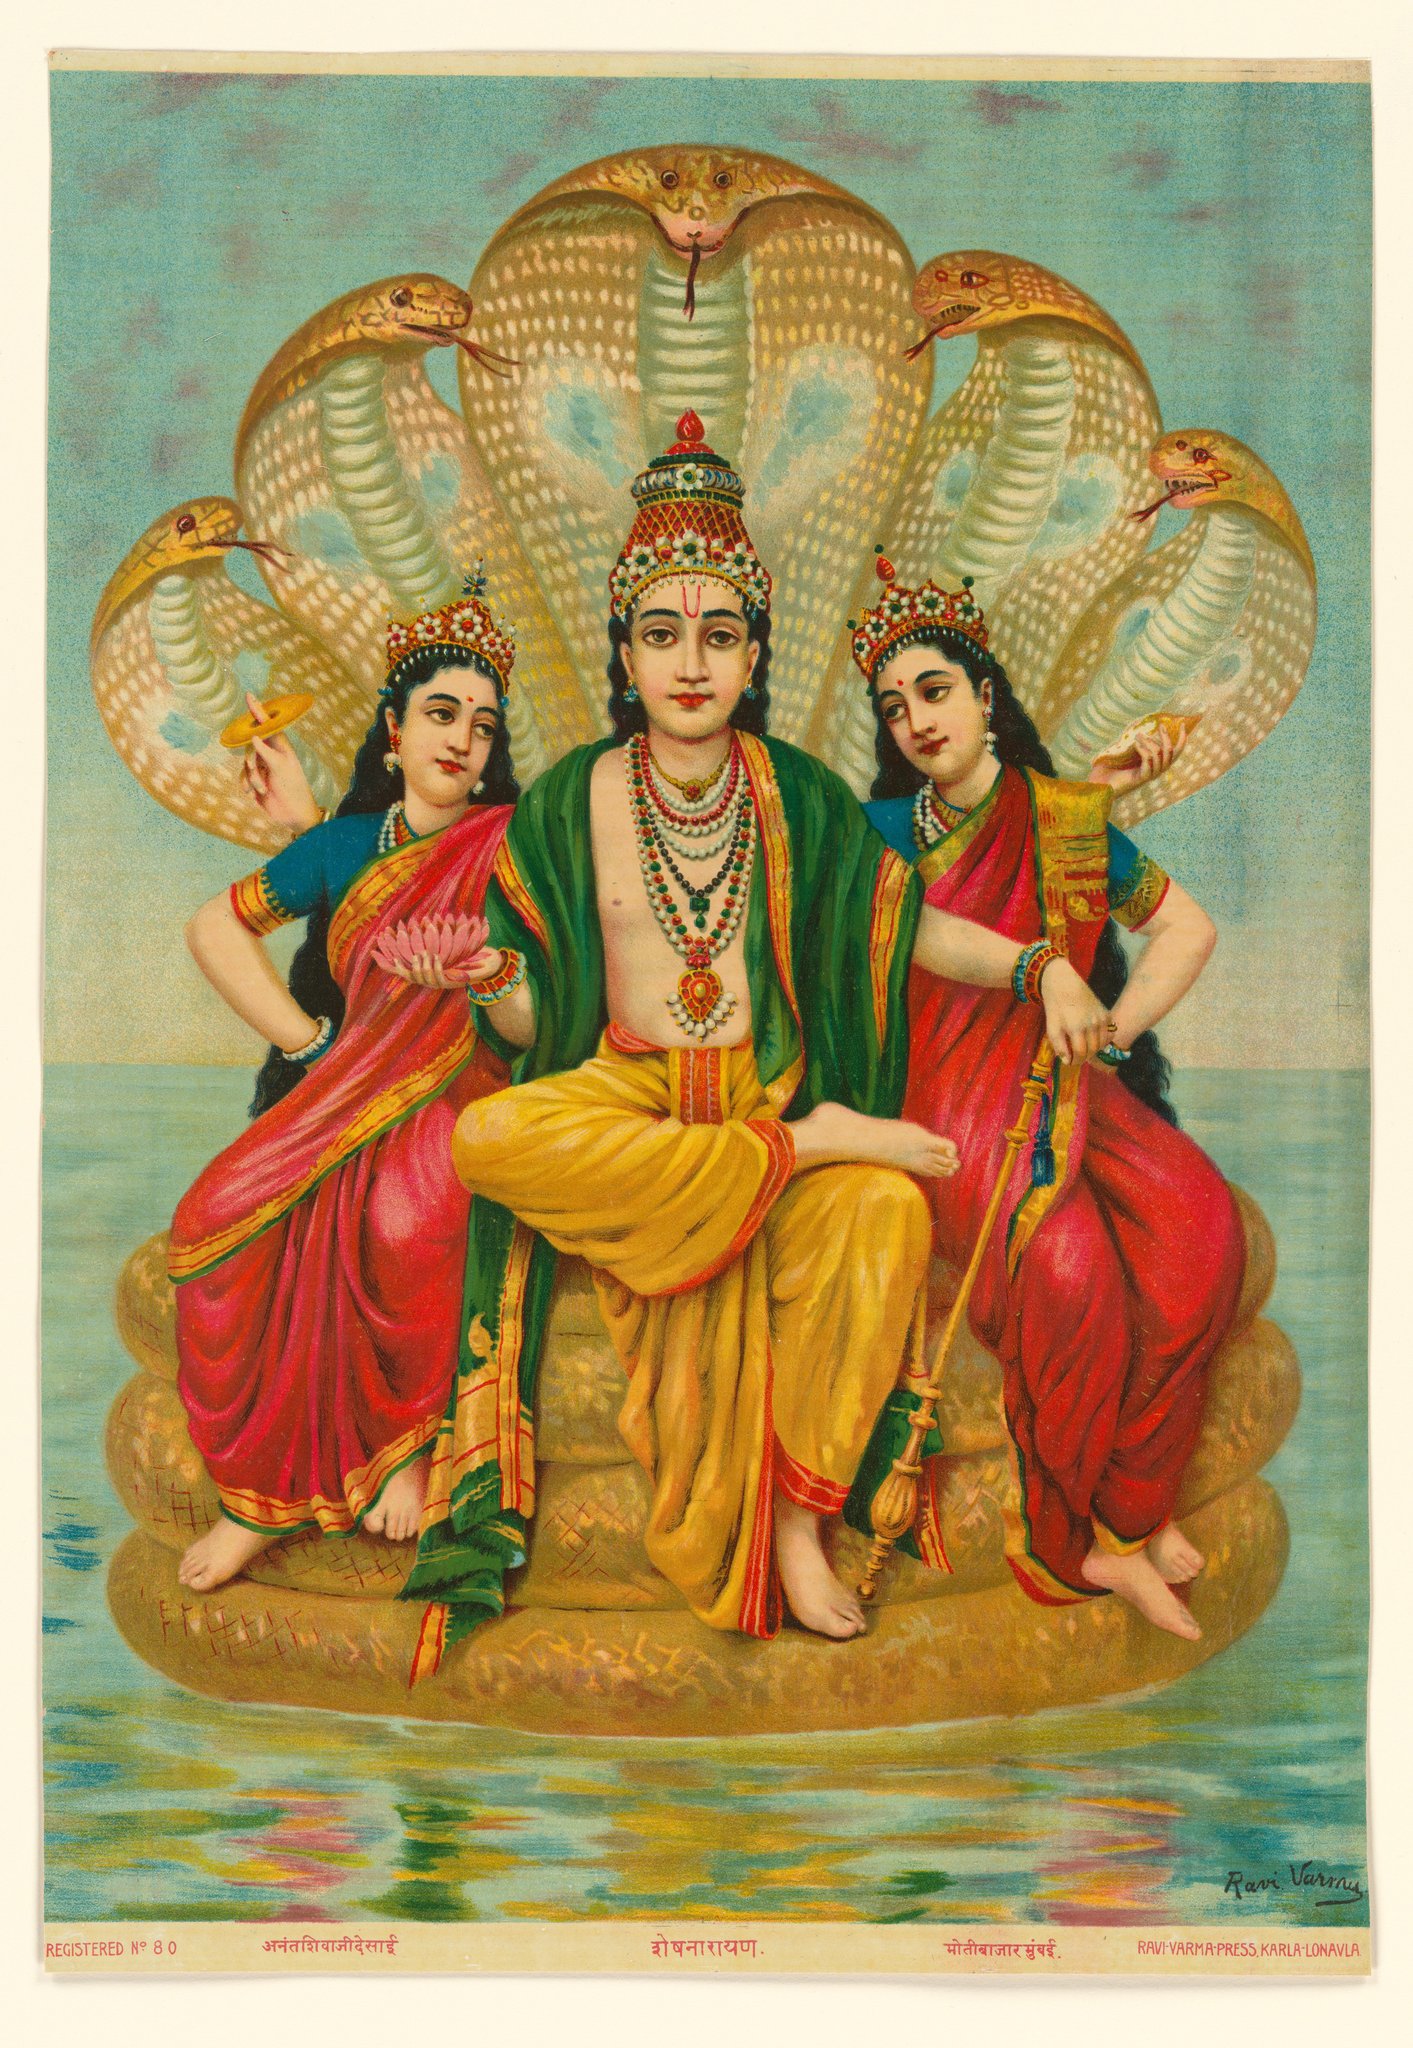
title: Shesha Narayana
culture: indian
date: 1900-1915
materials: varnish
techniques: lithograph